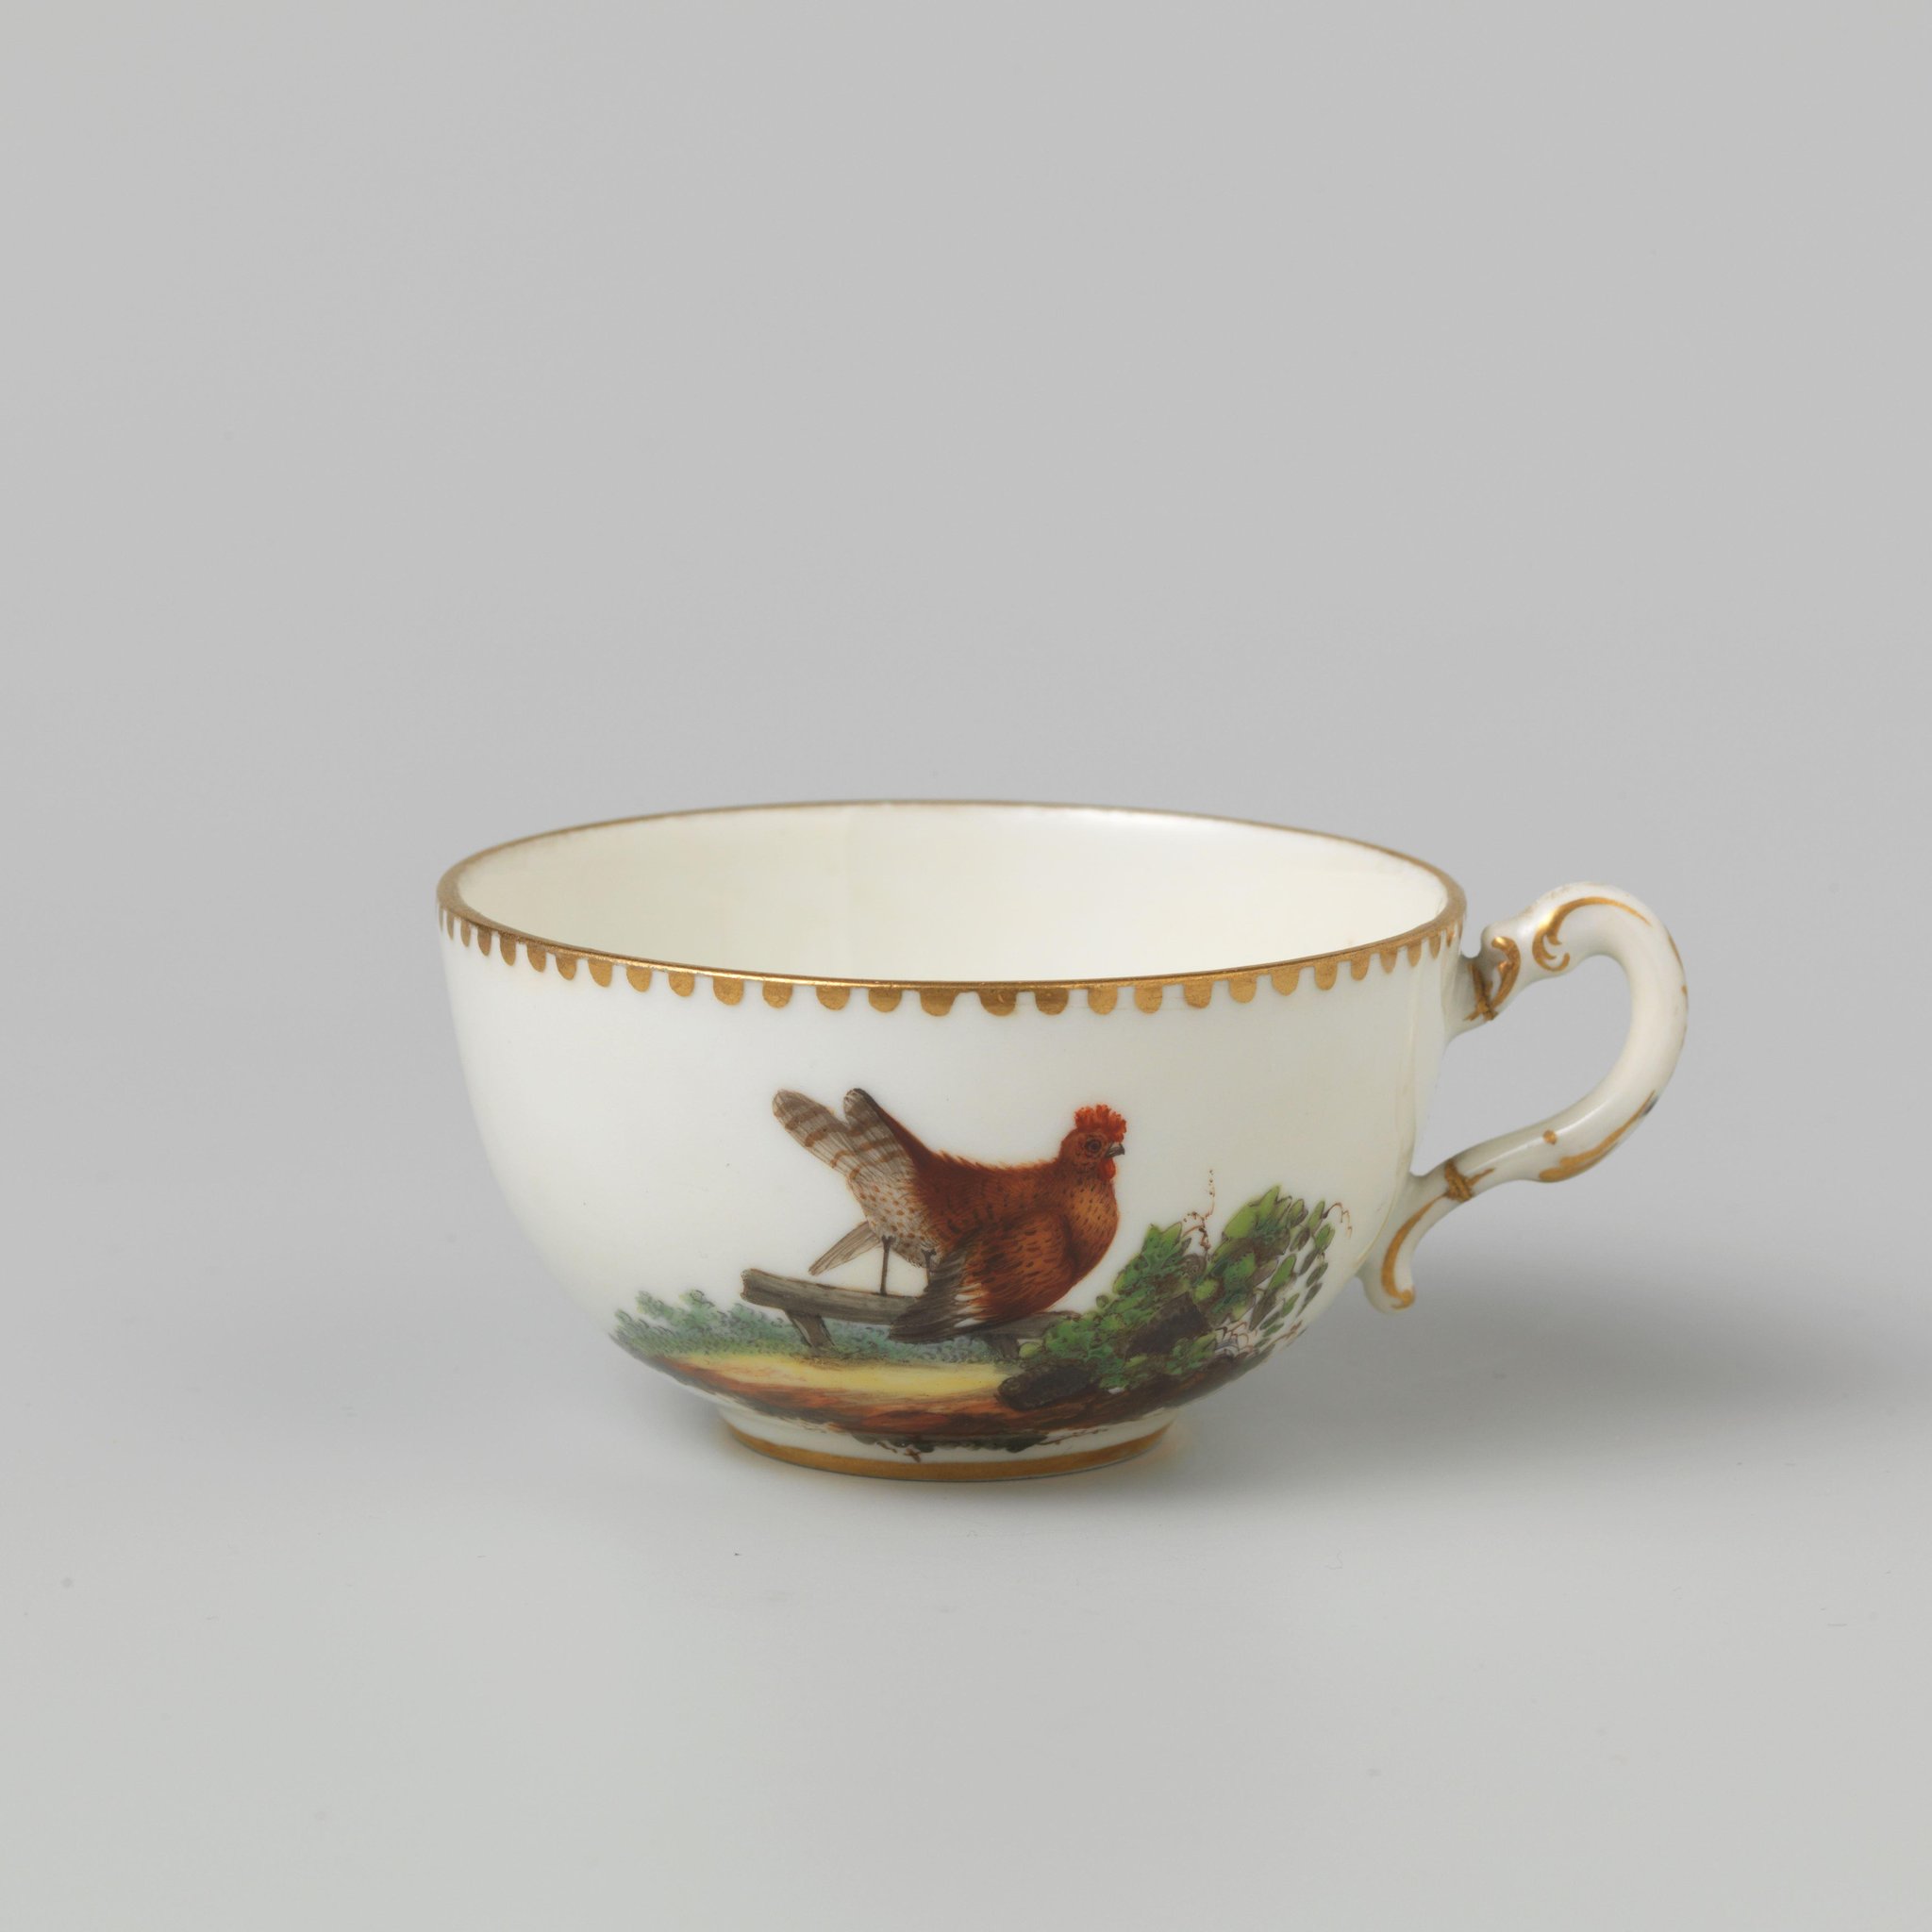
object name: cup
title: Kop, beschilderd met pluimvee in een landschap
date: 1782-1784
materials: porcelain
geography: loosdrecht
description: Kop met oor van porselein. Veelkleurig beschilderd met vogels op een landschapsgrondje, en strooibloemen.